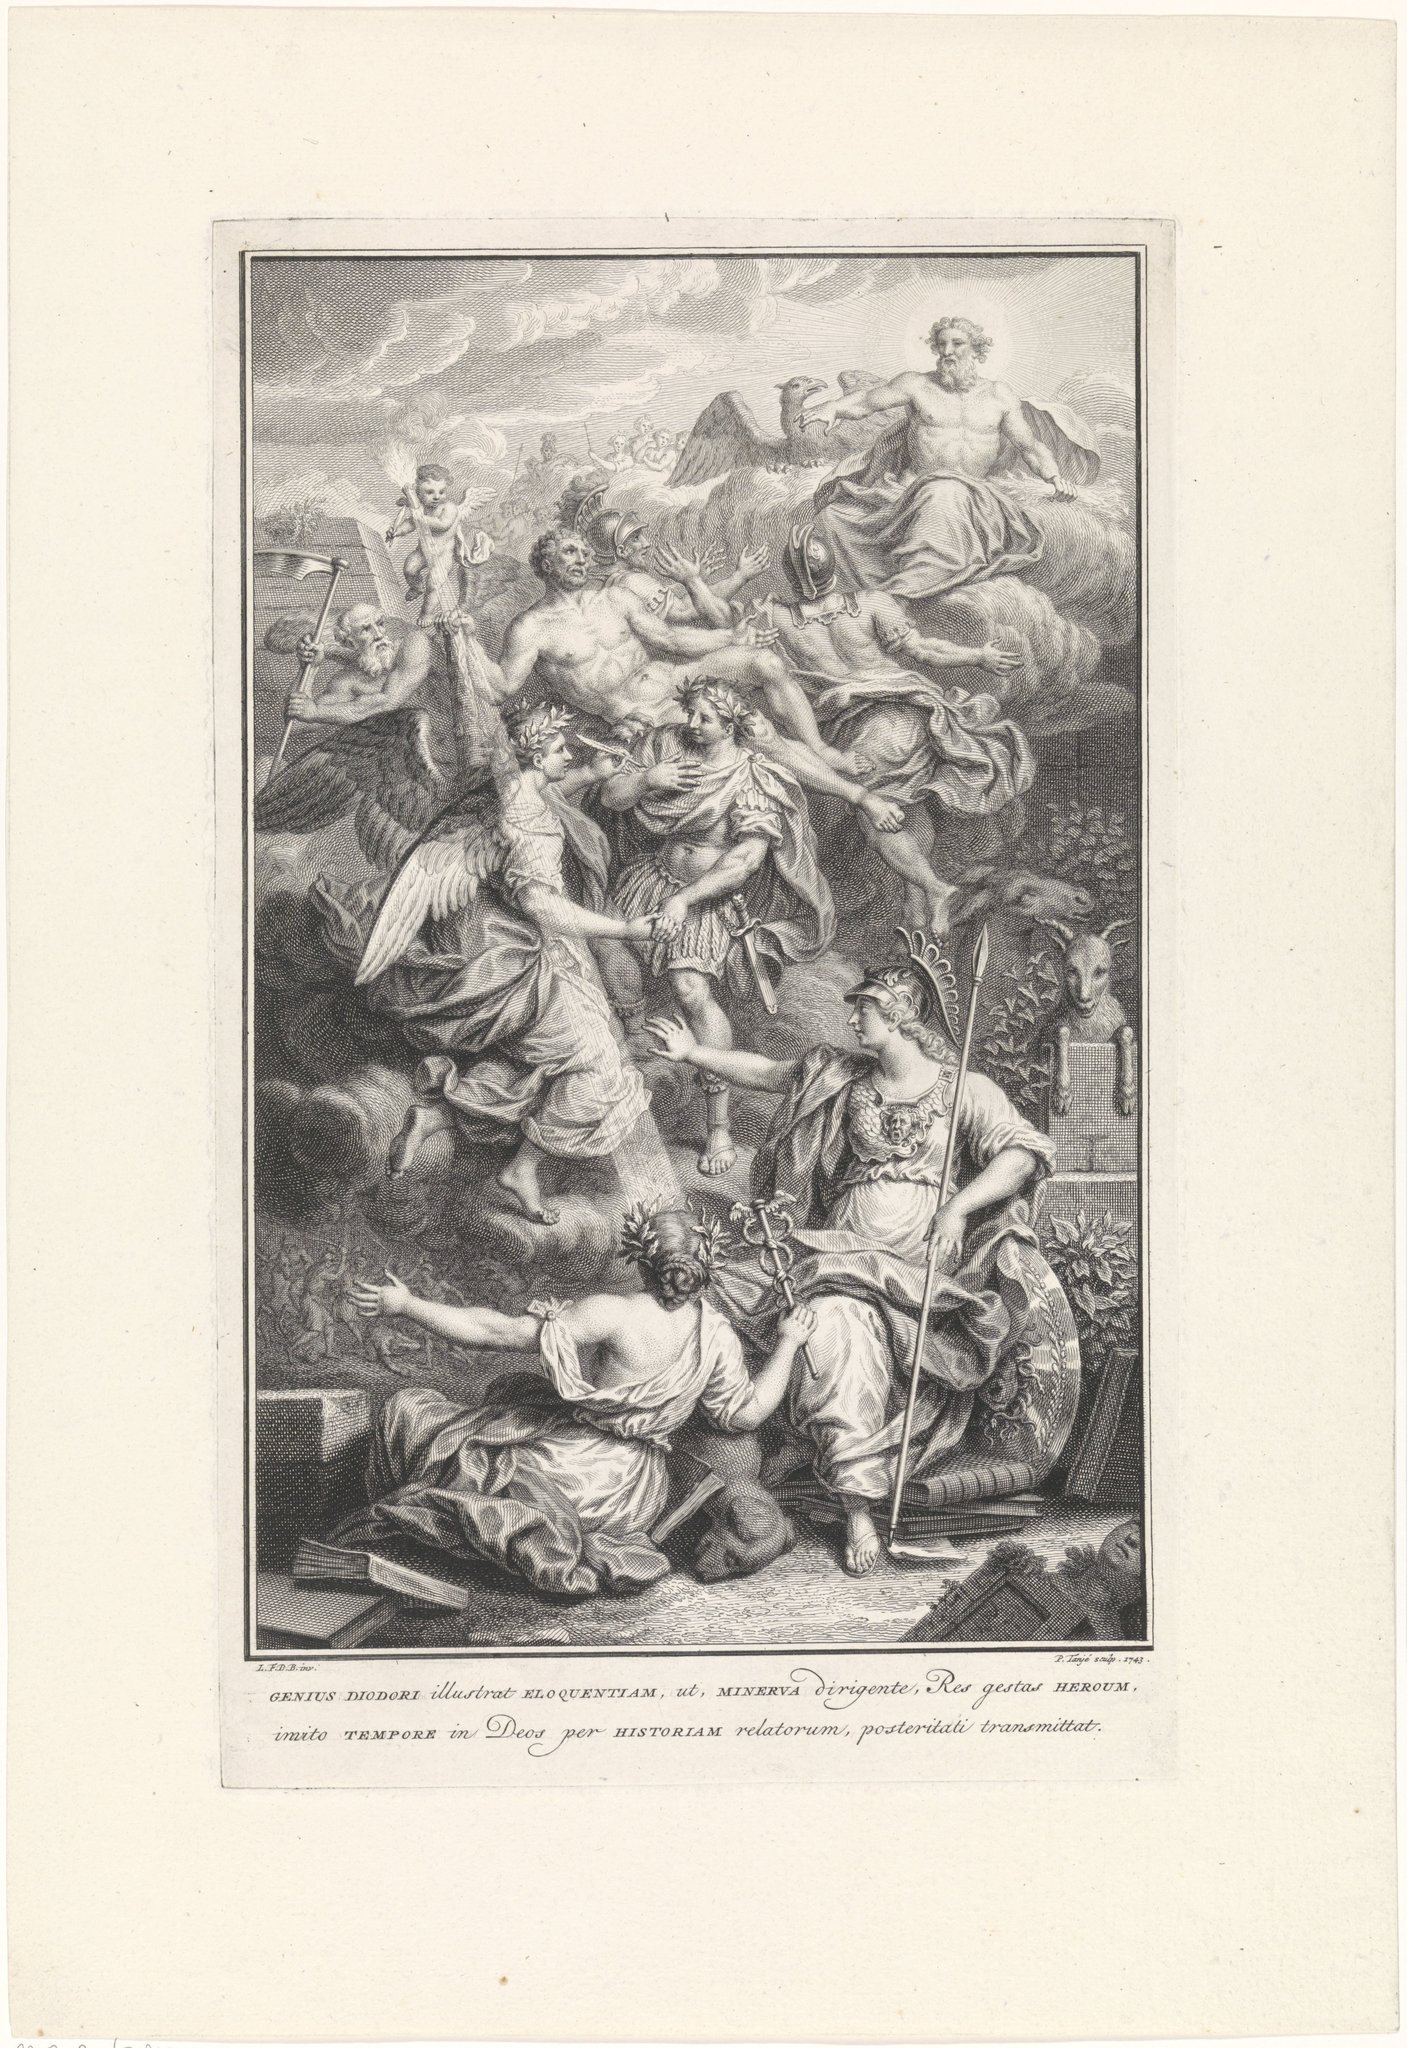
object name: print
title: Apotheose van helden onder de regering van Minerva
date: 1743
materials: paper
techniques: engraving, etching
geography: amsterdam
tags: (story of) jupiter (zeus), eloquence; 'eloquenza', 'fermezza & gravità dell'oratione' (ripa), specific aspects, allegorical aspects of minerva; minerva as patroness, heroes, male characters from the legendary origins of rome, father time, man with wings and scythe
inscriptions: collector's mark: Lugt 240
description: Allegorische voorstelling die verbeeldt dat onder de regering van de godin van de wijsheid Minerva welbespraaktheid en heldendom bloeien. Op de voorgrond zit Minerva op een stapel boeken, met haar speer in de handen. Naast haar een vrouw op de rug gezien, wellicht een muze, met de caduceus. Op de wolken klimmen helden naar de Olympus, waar Jupiter hen wacht. Vader Tijd kijkt vergeefs toe en ziet hoe de helden zich eeuwige roem verschaffen.